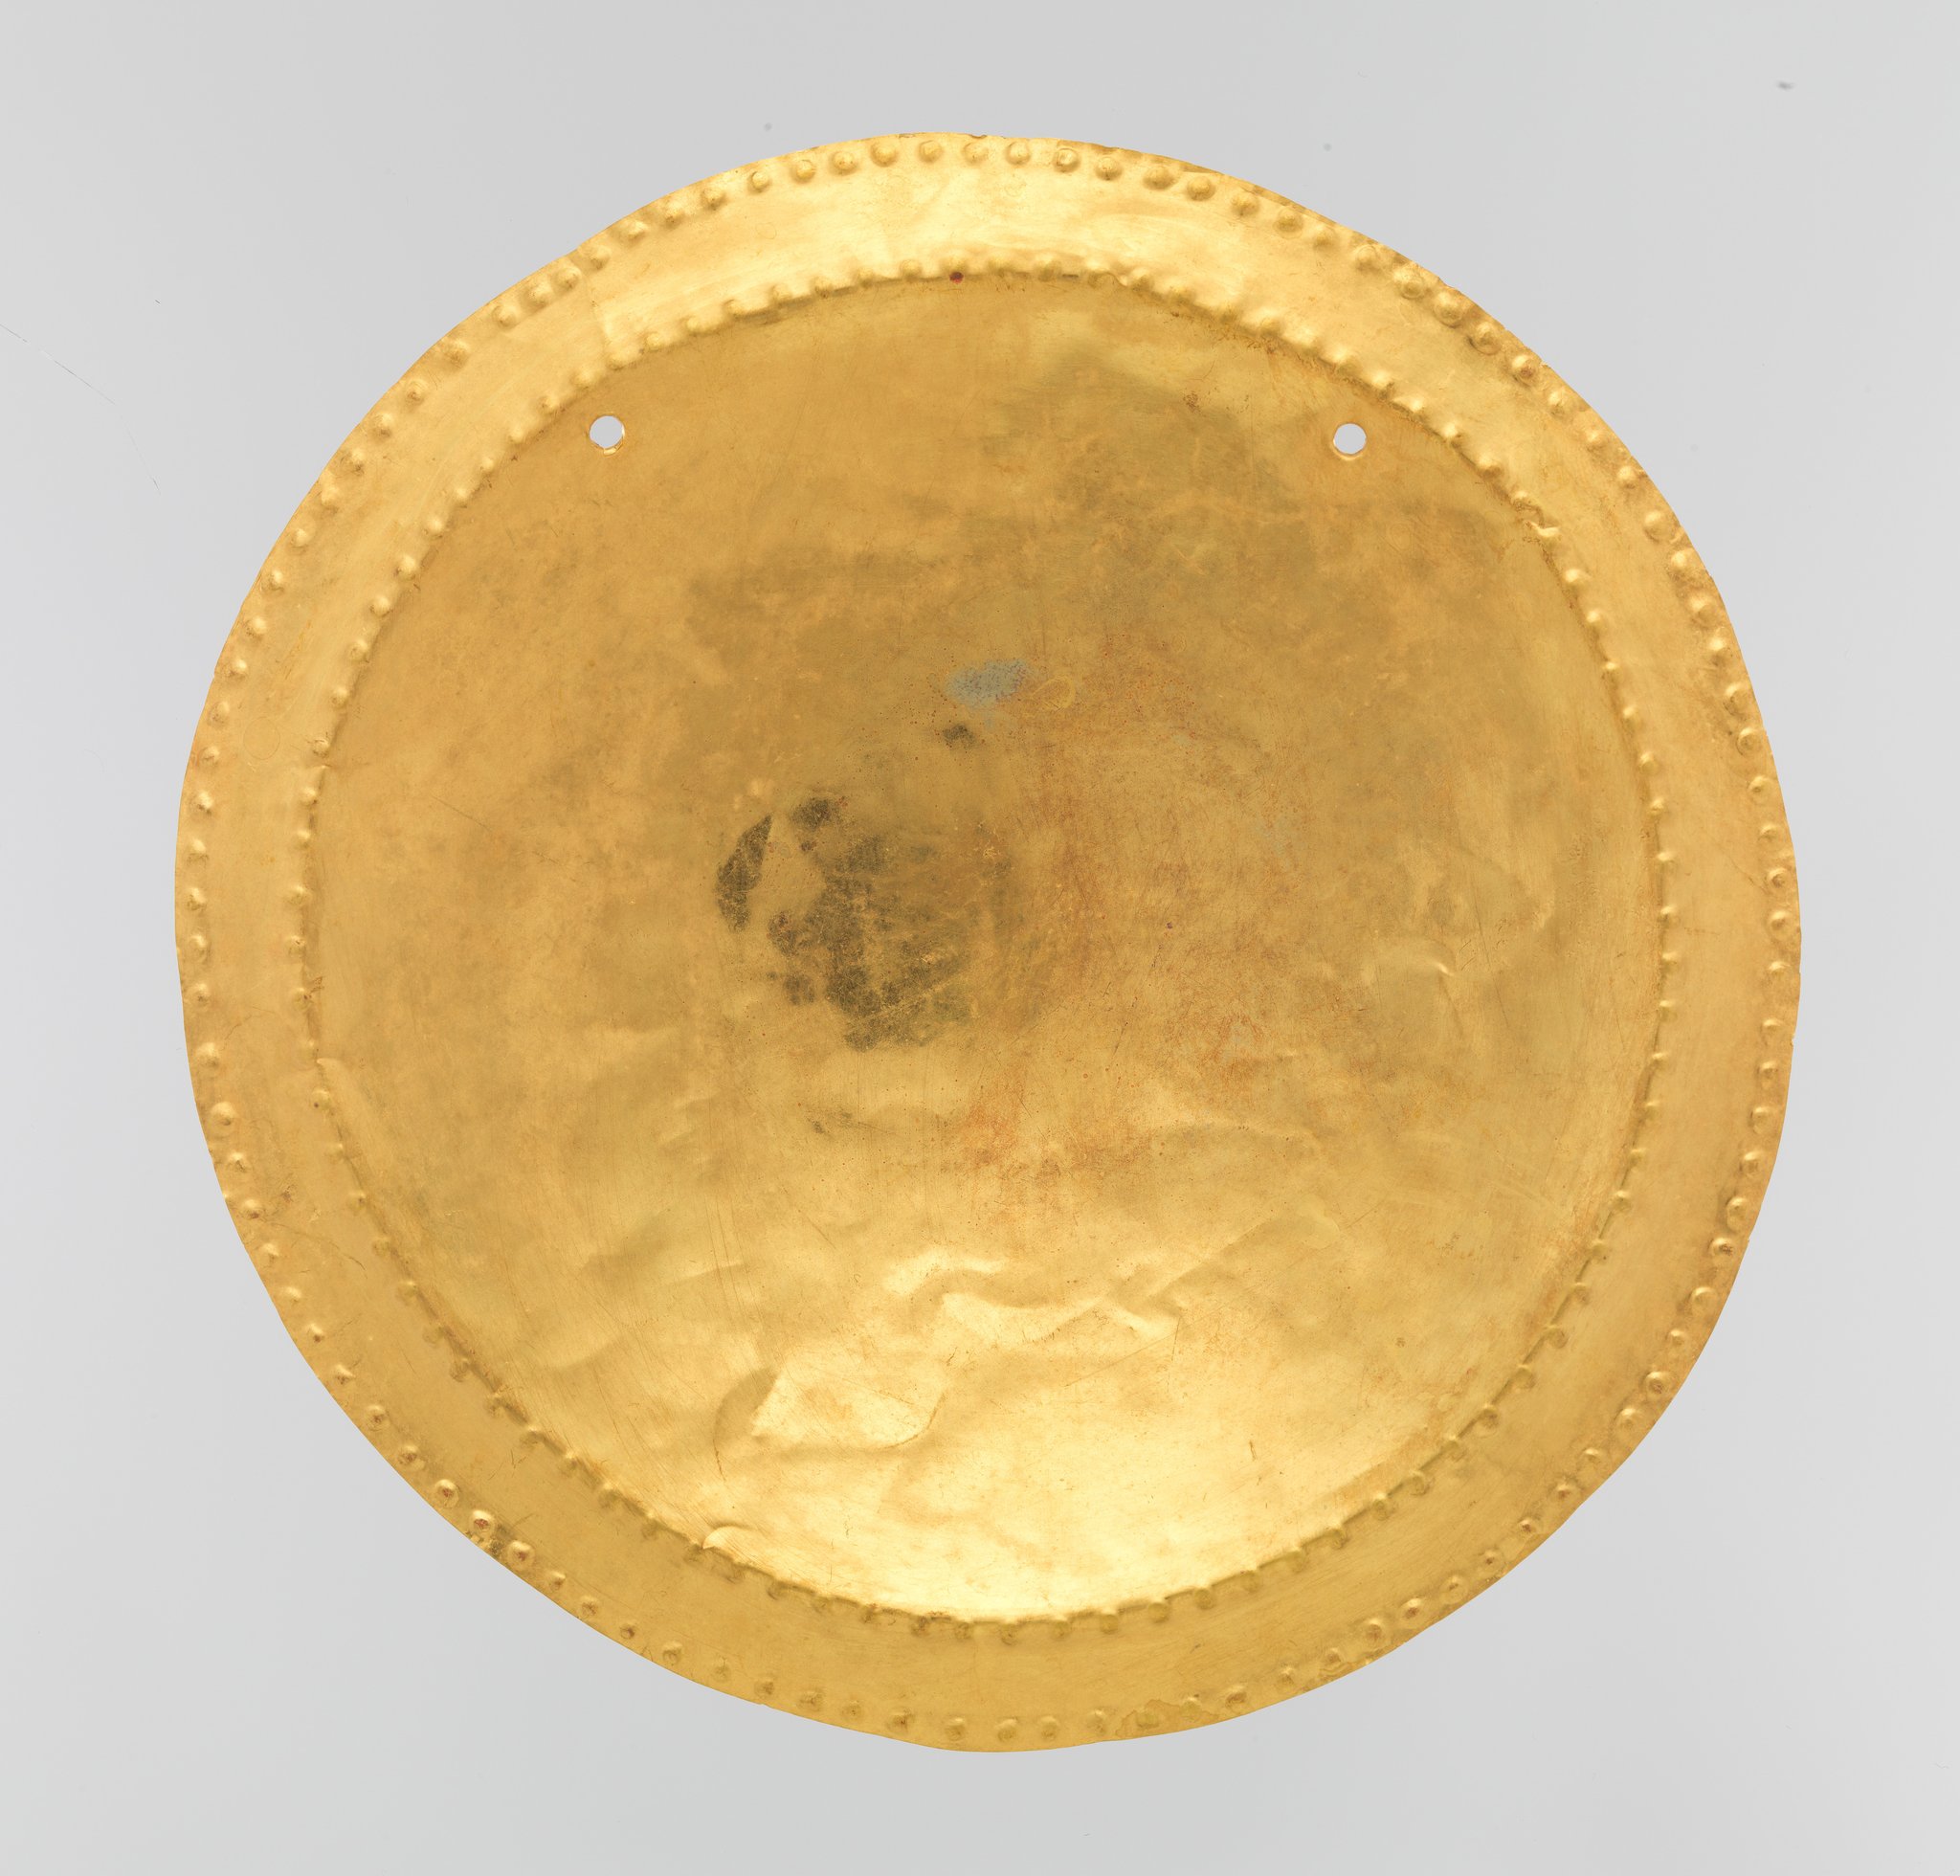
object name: pectoral disk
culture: coclé, macaracas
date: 701-1200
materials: gold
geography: panama